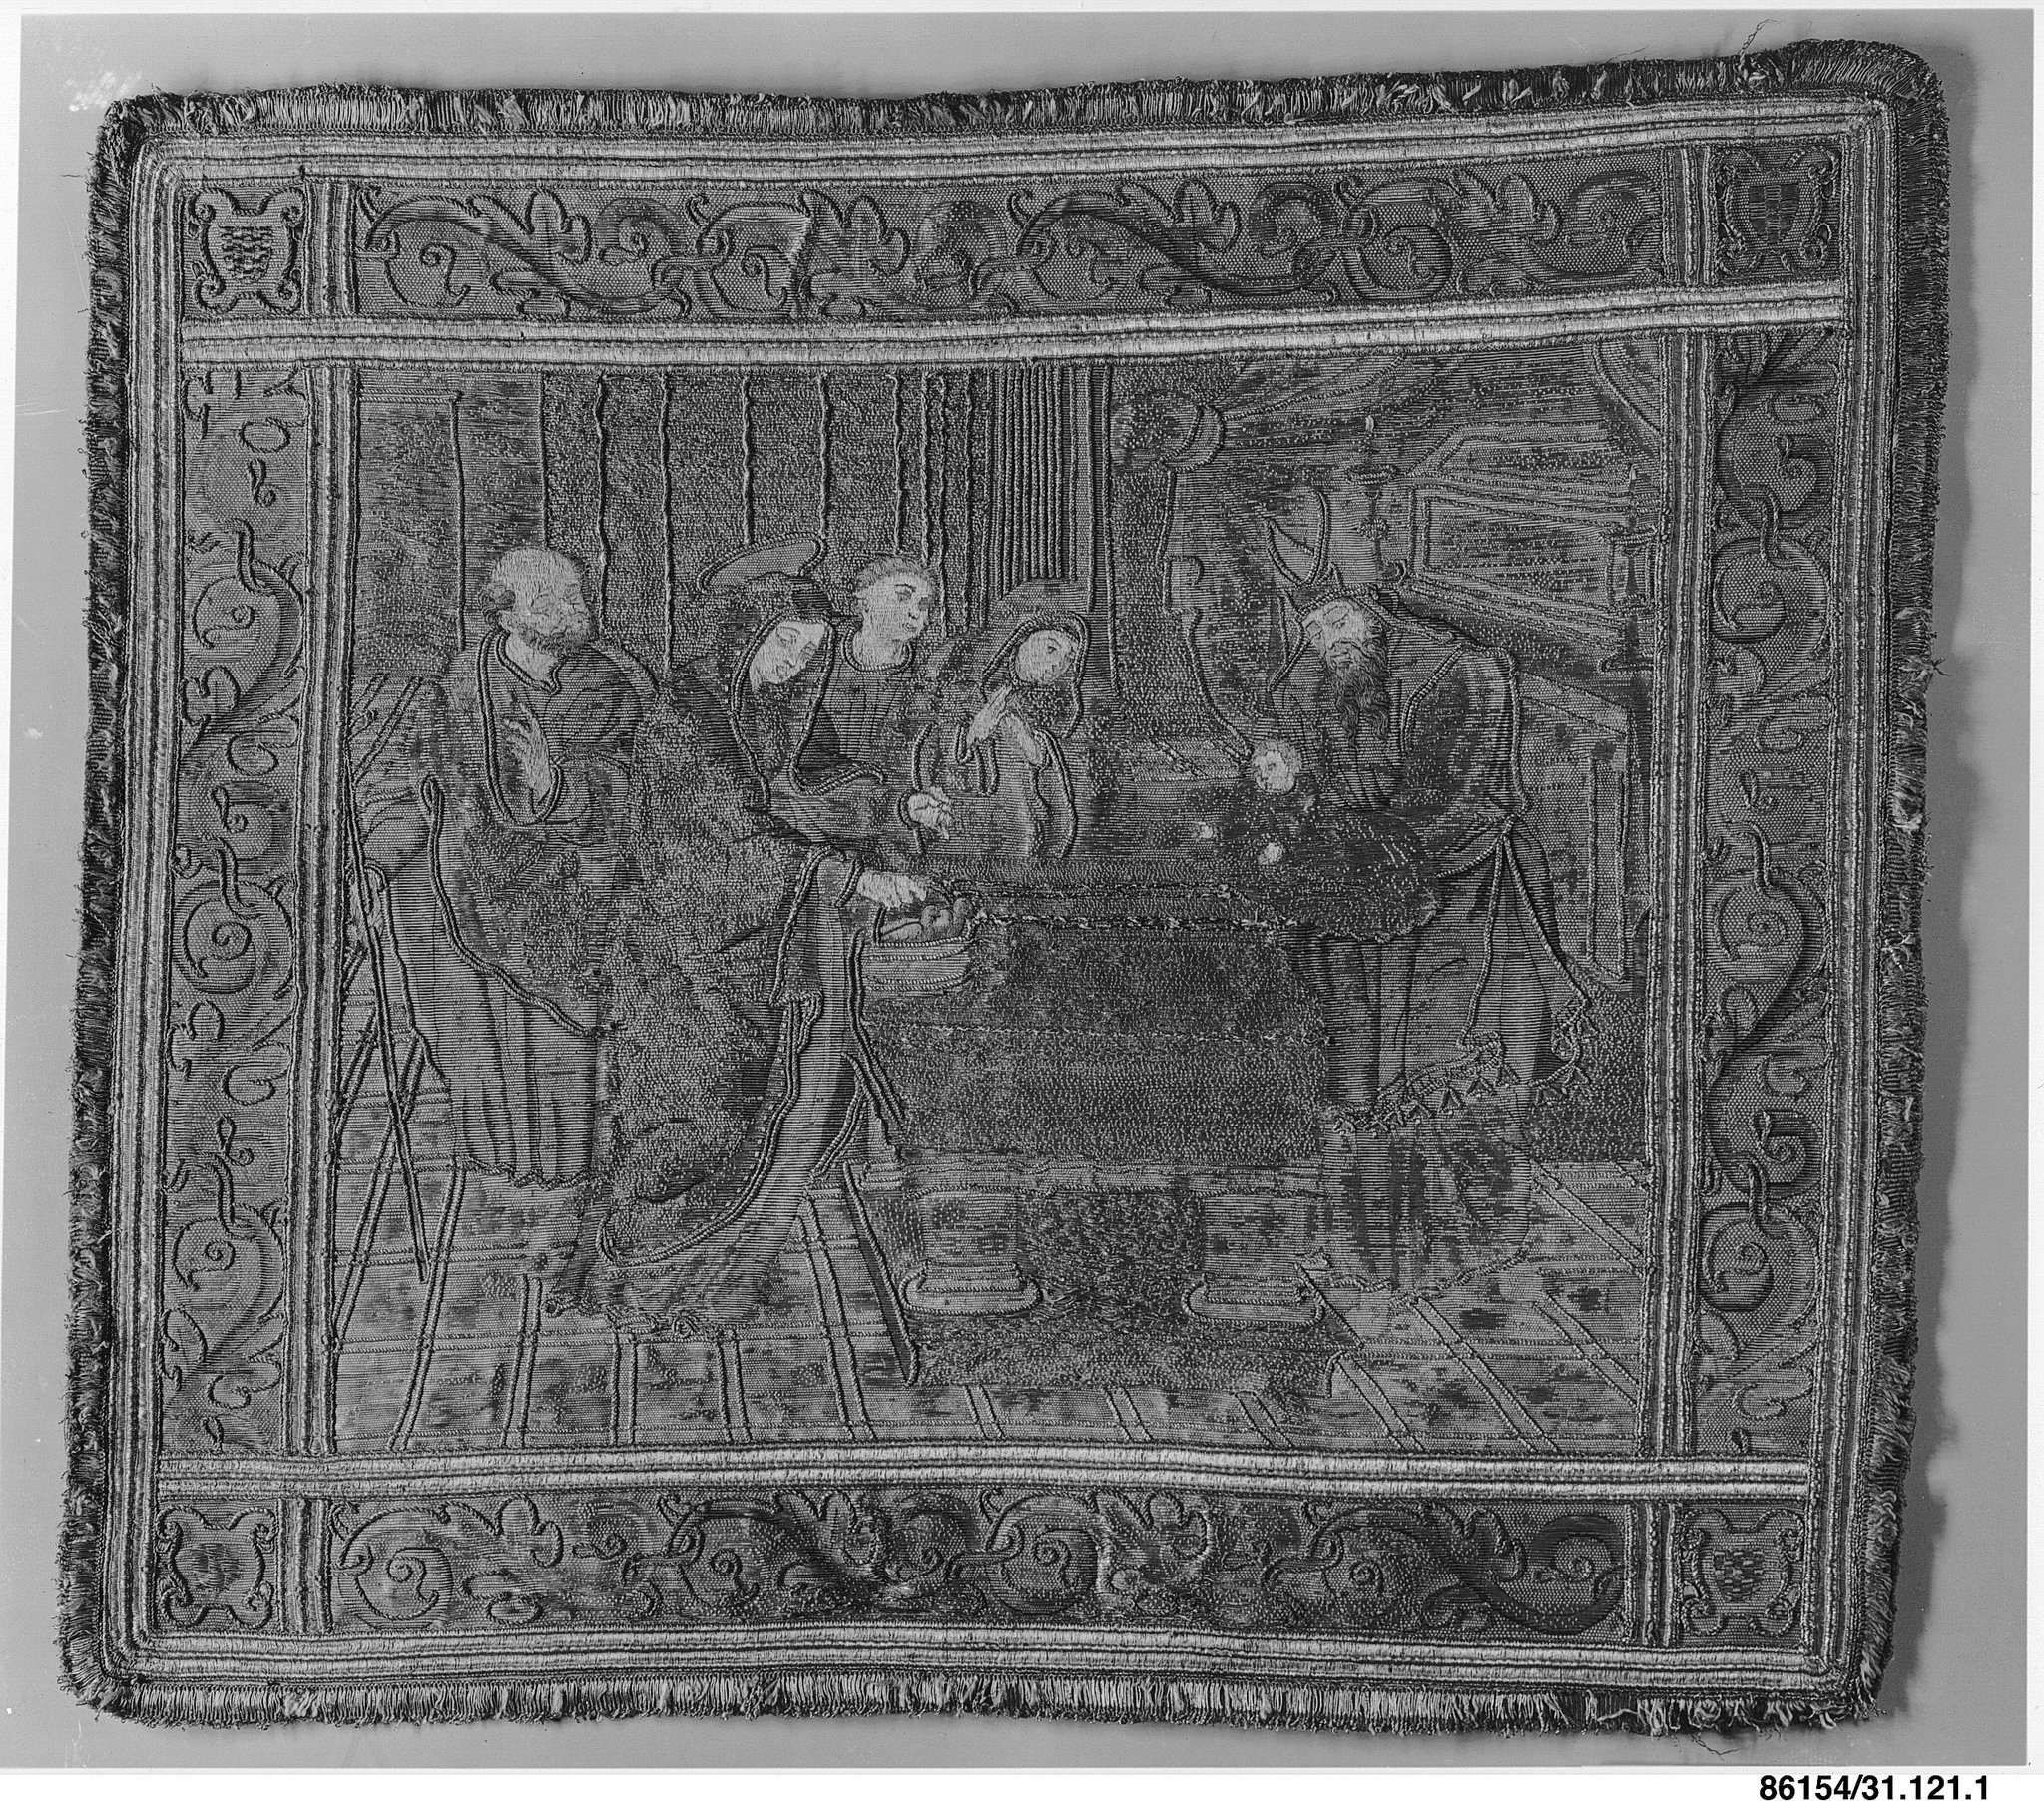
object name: panel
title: The Presentation in the Temple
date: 1501-1533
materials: linen, metal thread, silk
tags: men,virgin mary,jesus